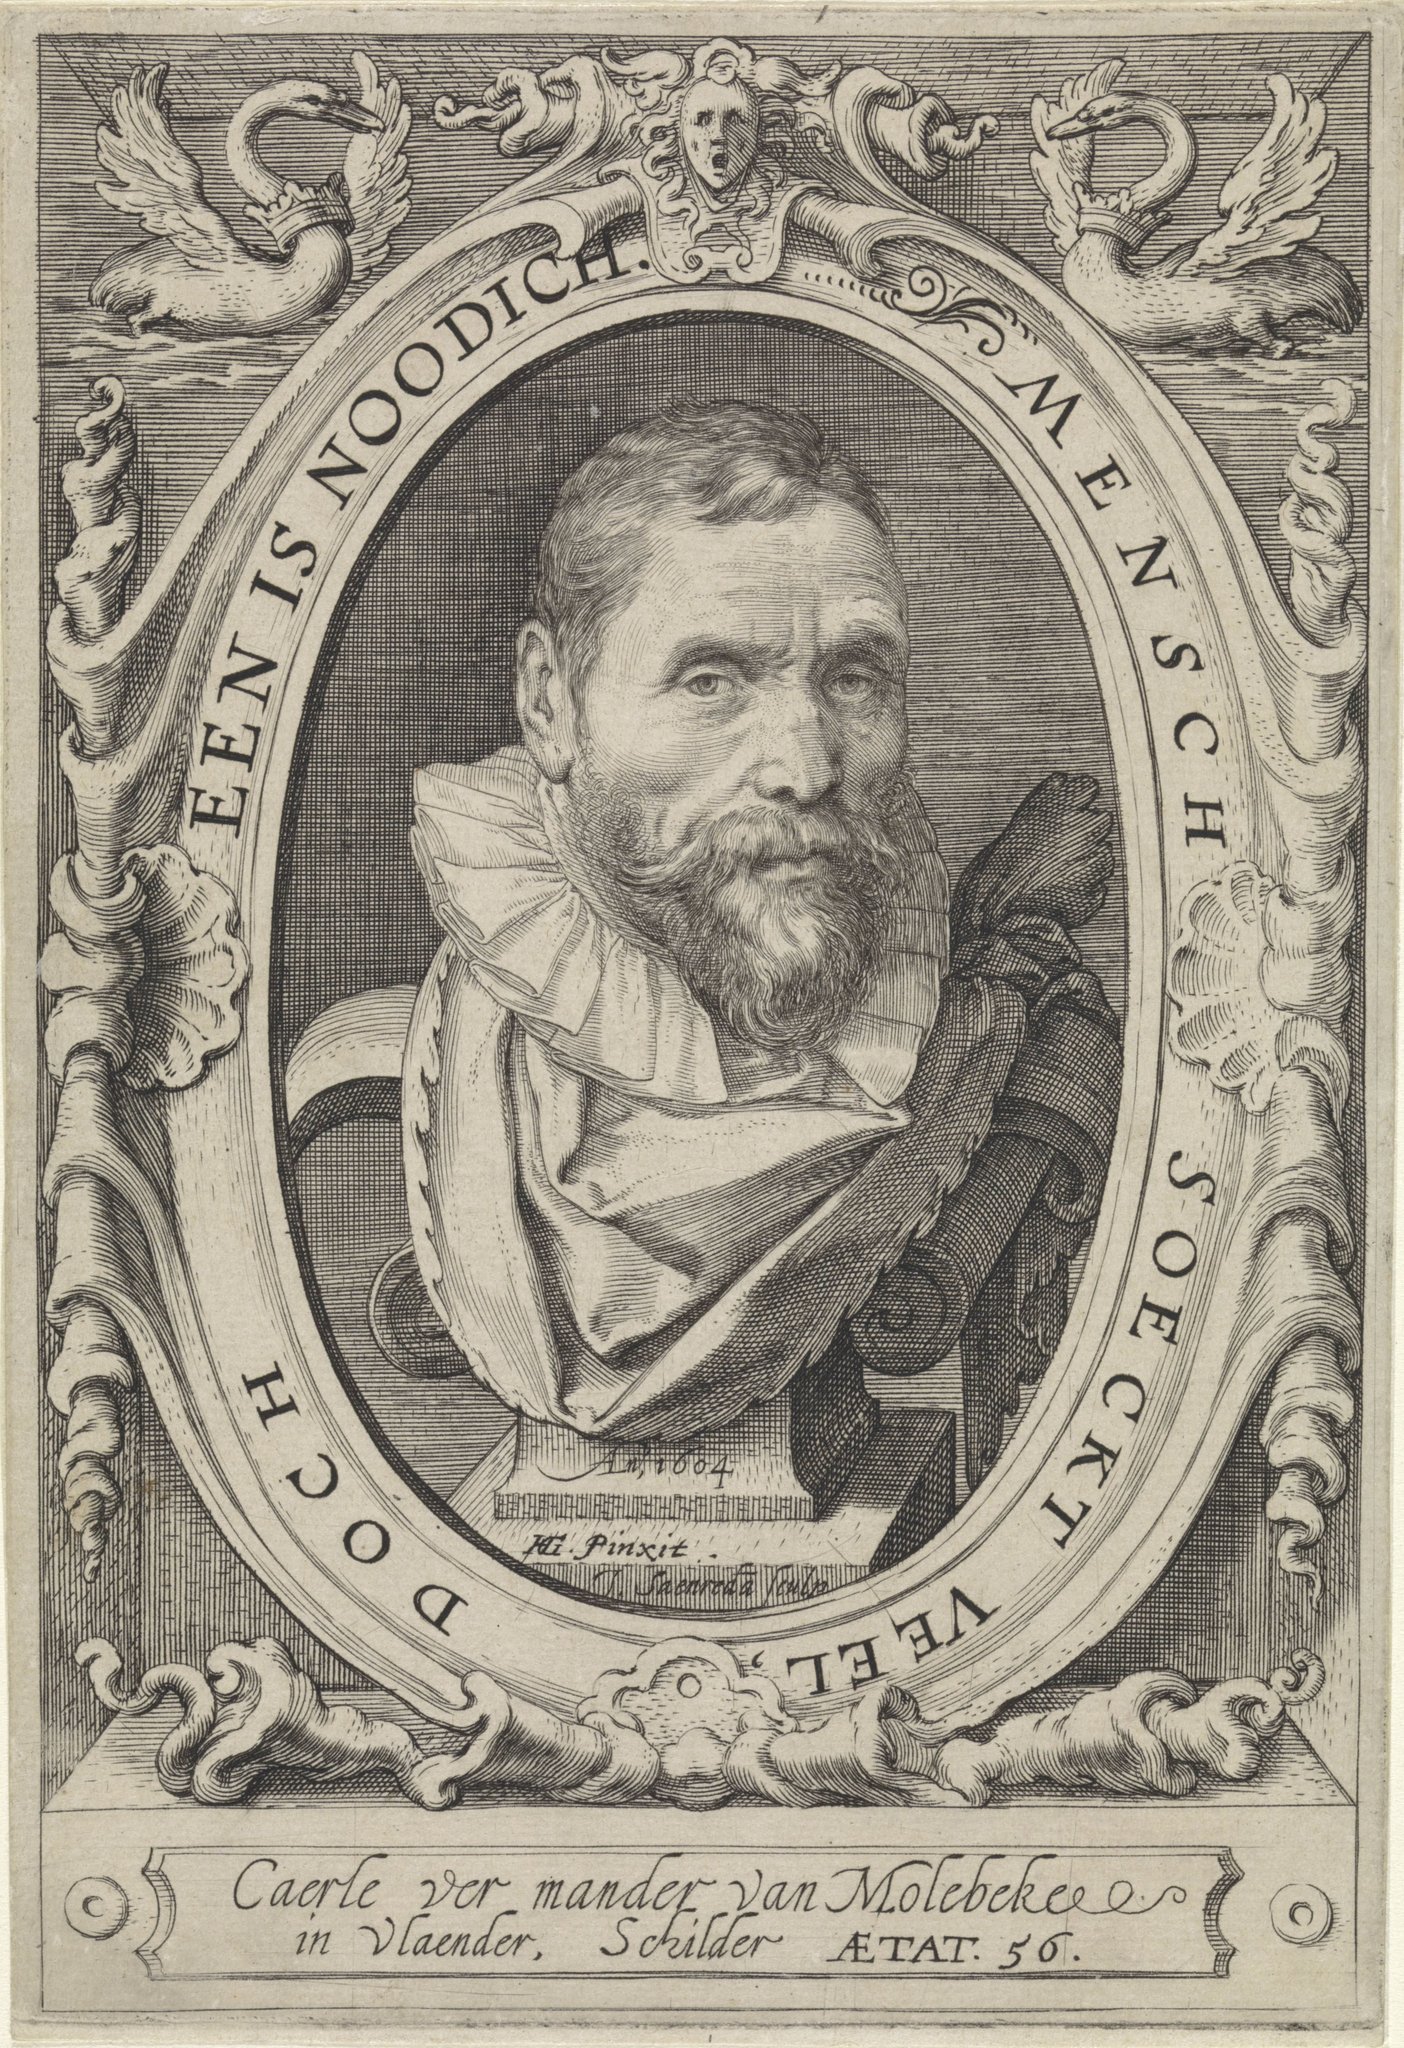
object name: print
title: Portret van Karel van Mander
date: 1604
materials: paper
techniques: engraving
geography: haarlem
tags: amsterdam, painter, print maker, draughtsman, karel van mander (i), portrait, self-portrait of artist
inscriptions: collector's mark: Lugt 240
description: Buste van Karel van Mander in een ornamentele, ovale omlijsting met de tekst: Een is noodich. Mensch soeckt veel, doch. Linksboven en rechtsboven een zwaan met een kroon om zijn hals. Onder de voorstelling de naam, functie en leeftijd (56) van de geportretteerde.